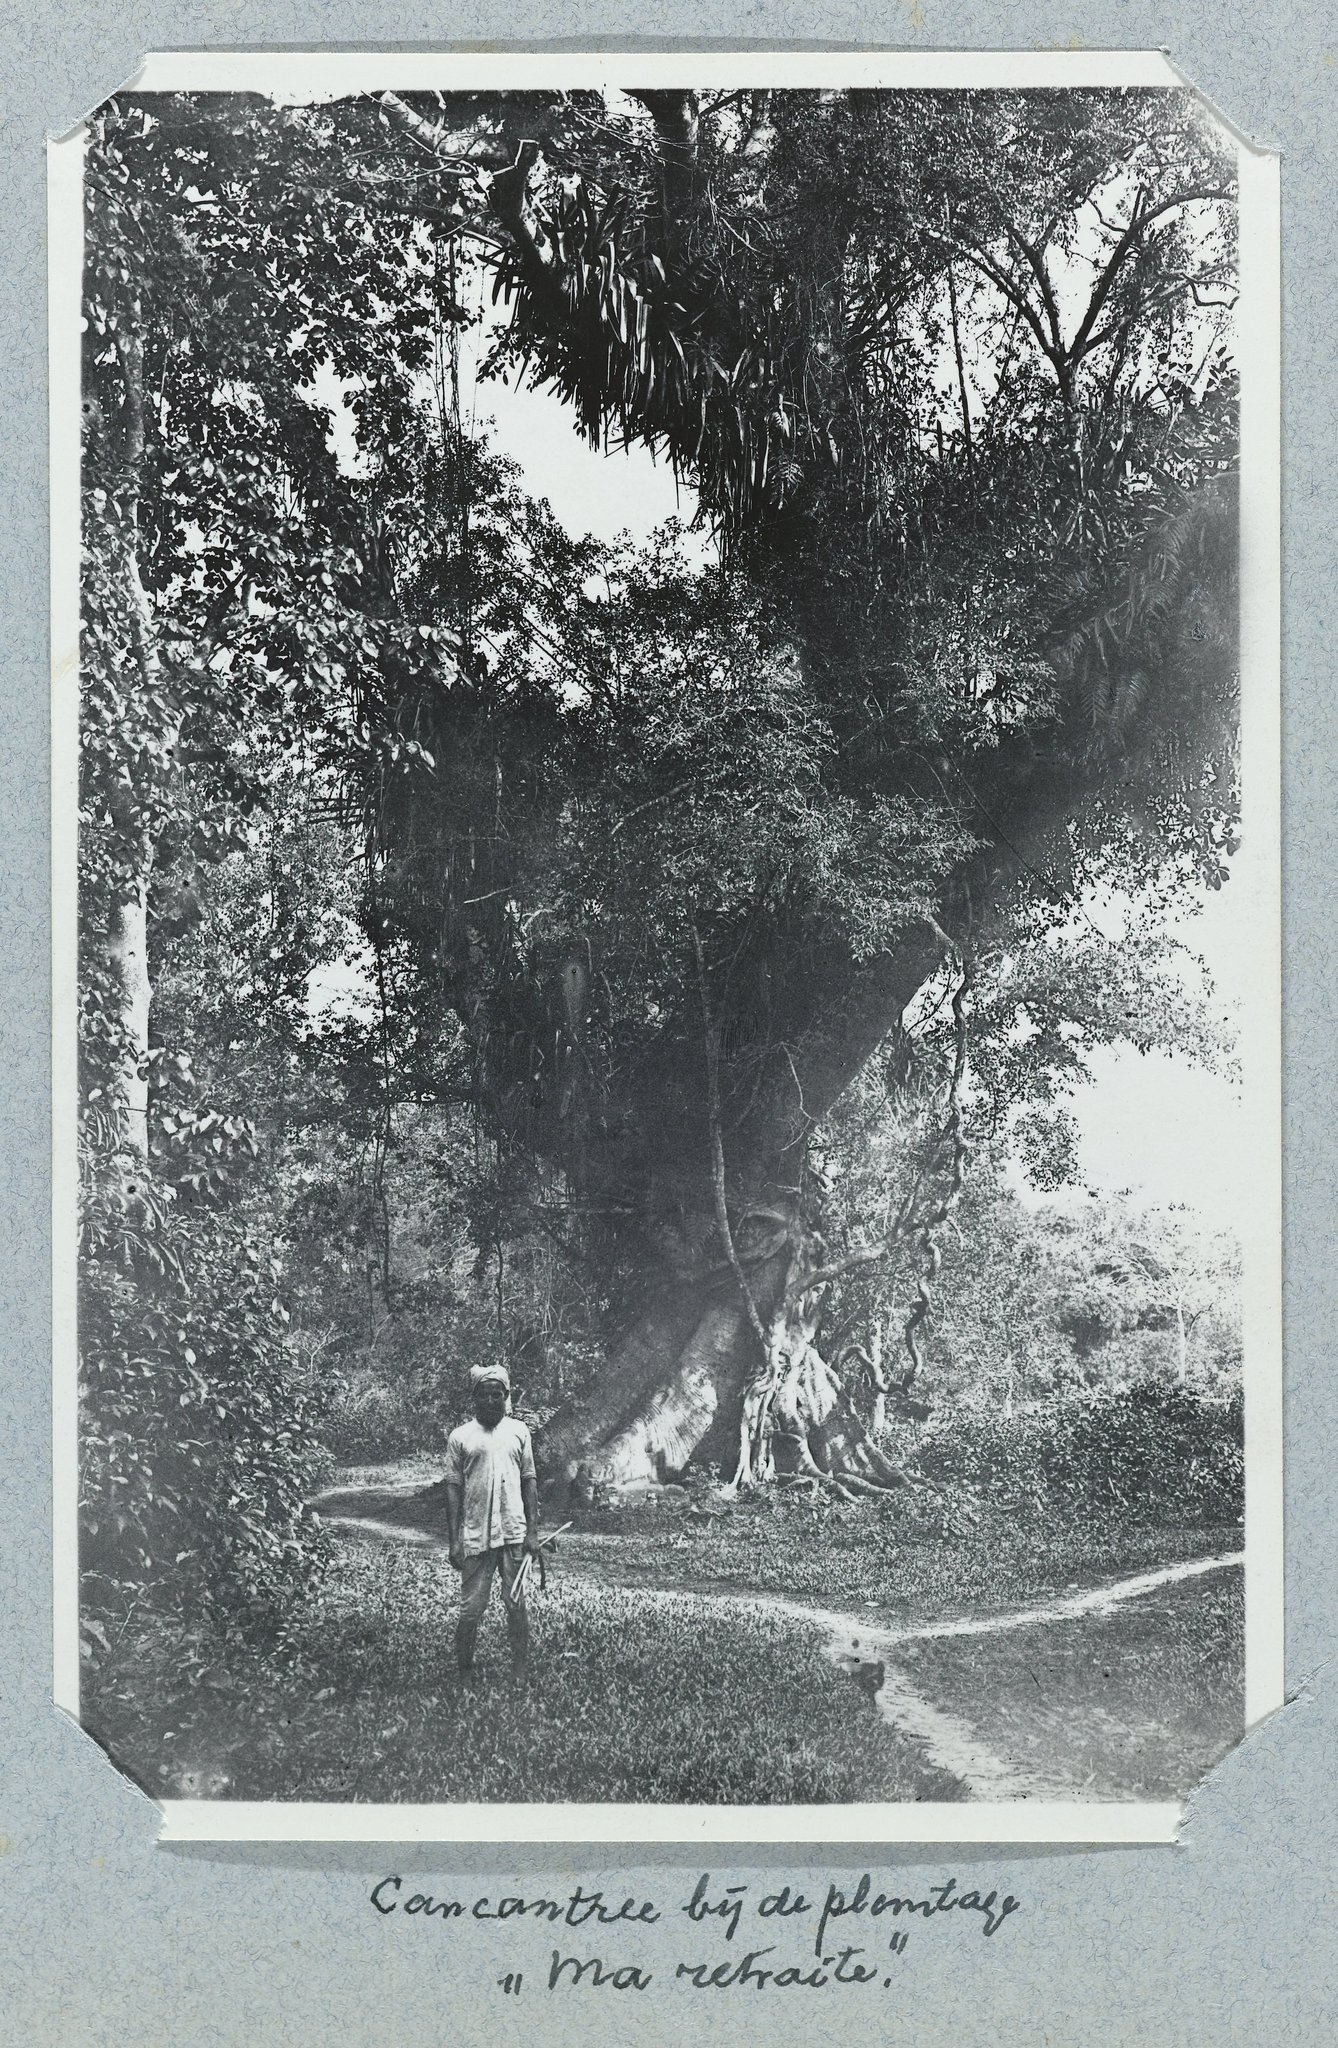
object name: photograph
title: Cancantree bij de plantage "Ma retraite"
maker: théodore van lelyveld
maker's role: painter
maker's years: 1867-1954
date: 1895-1898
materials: photographic support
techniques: gelatin silver print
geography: suriname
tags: plantation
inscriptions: inscription: ‘Cancantree bij de plantage "Ma retraite".’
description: Een grote kankantrie, een wilde kapokboom, bij de plantage Ma Retraite. Fotoafdruk in een fotoalbum van Théodore van Lelyveld over Suriname uit 1895-1898.